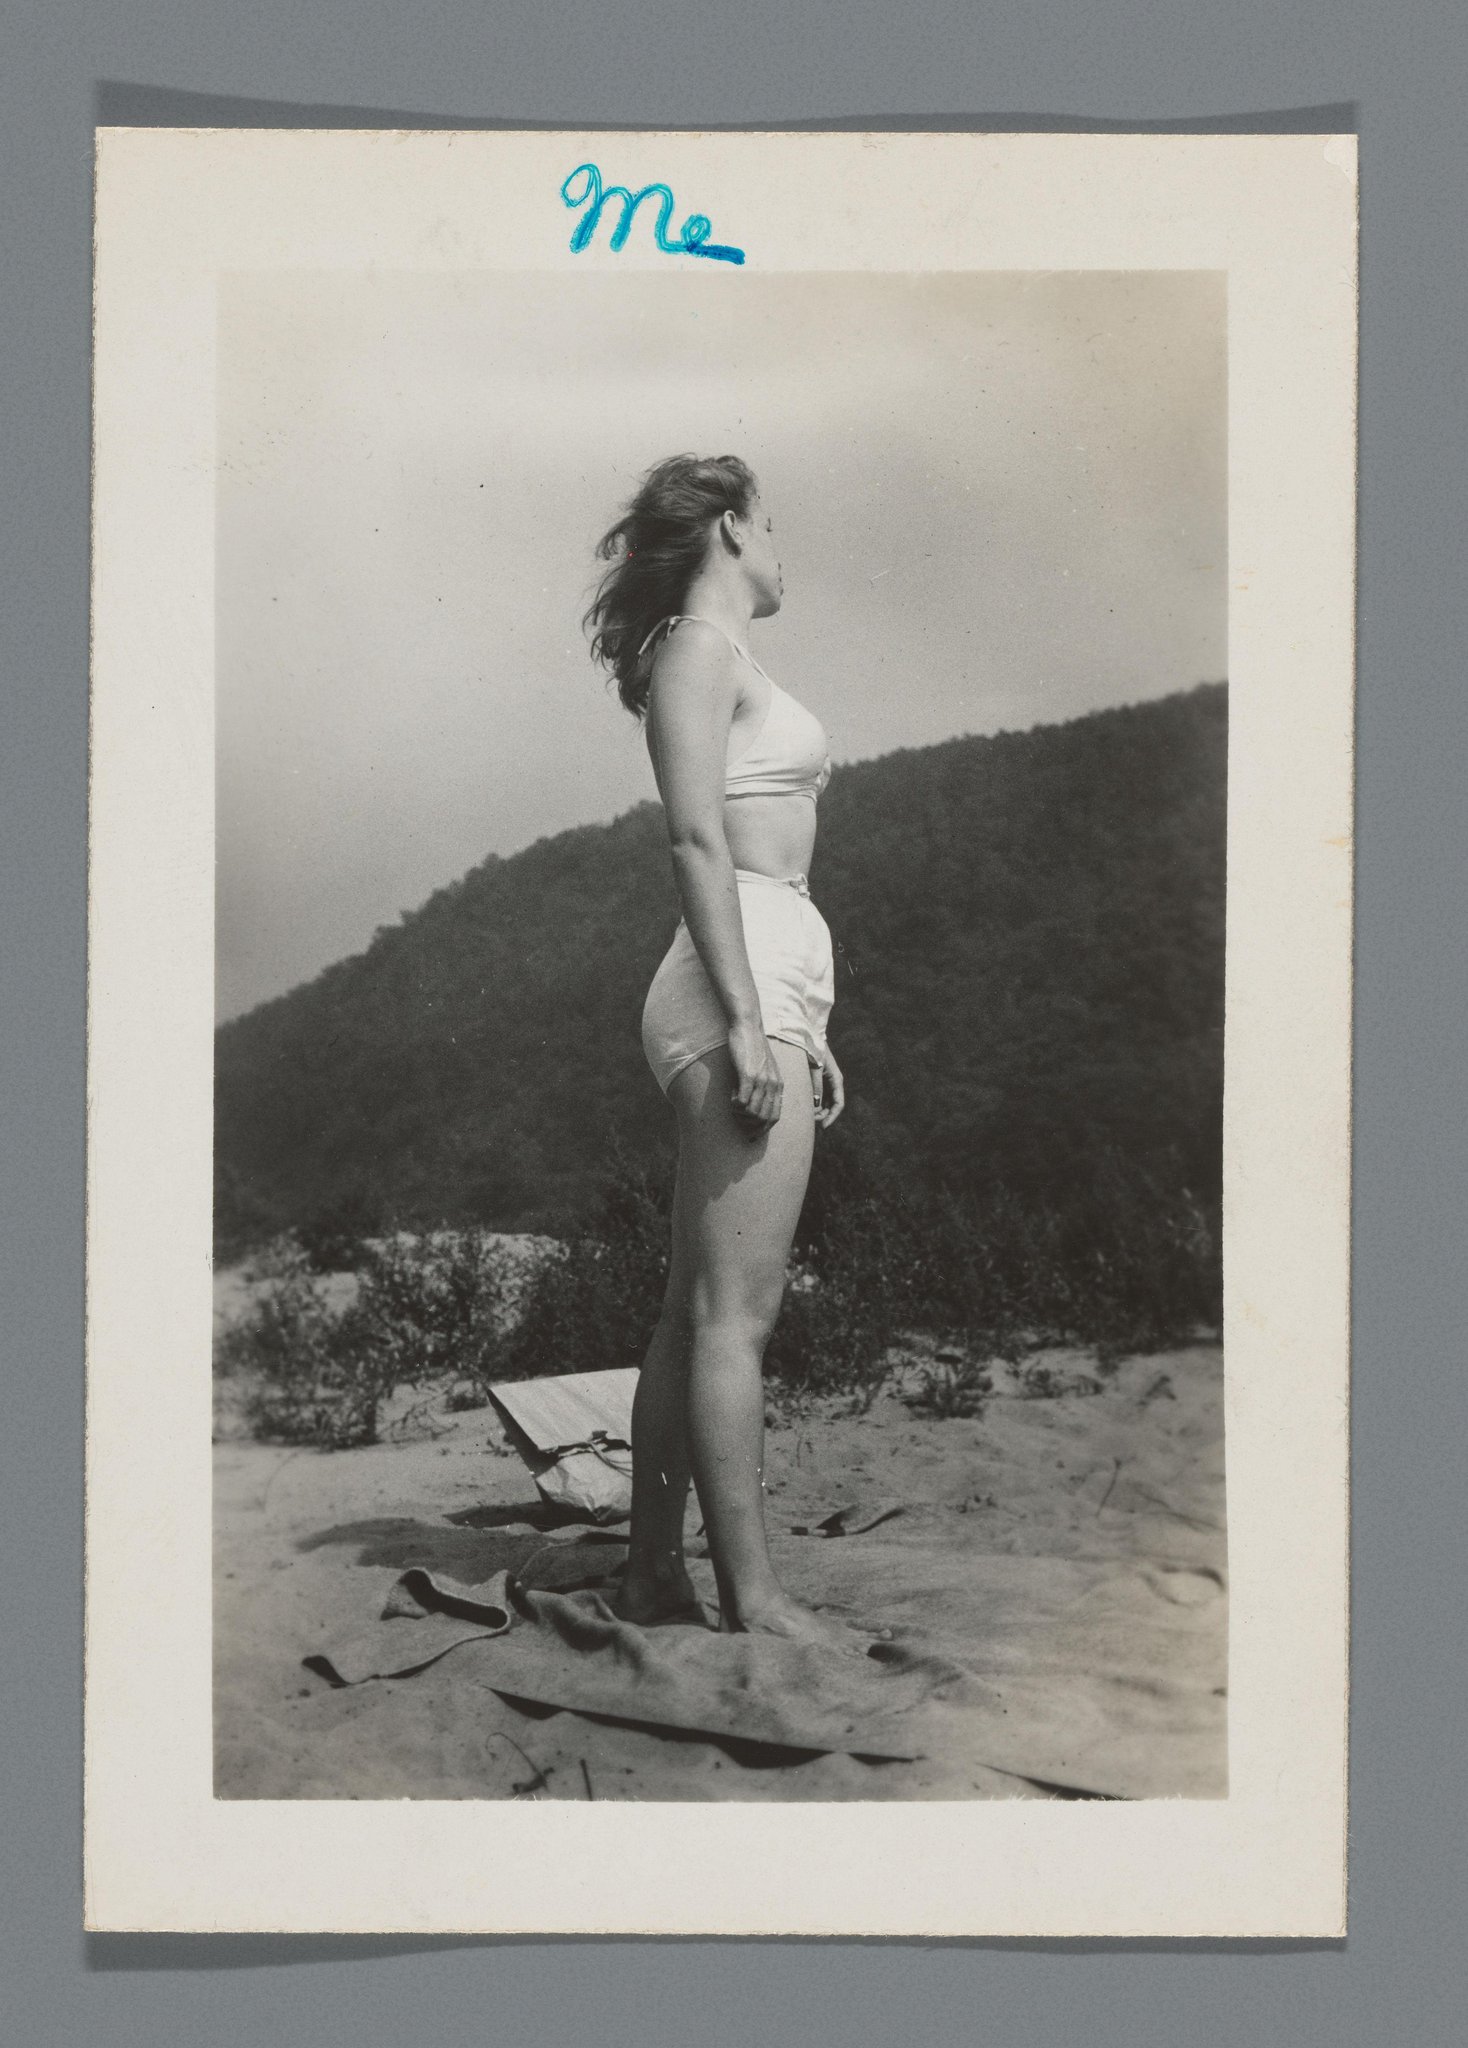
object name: photograph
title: Vrouw staand op een strand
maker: Anonymous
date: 1949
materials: paper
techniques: gelatin silver print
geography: united states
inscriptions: inscription: ‘Me’, stamp: ‘49’